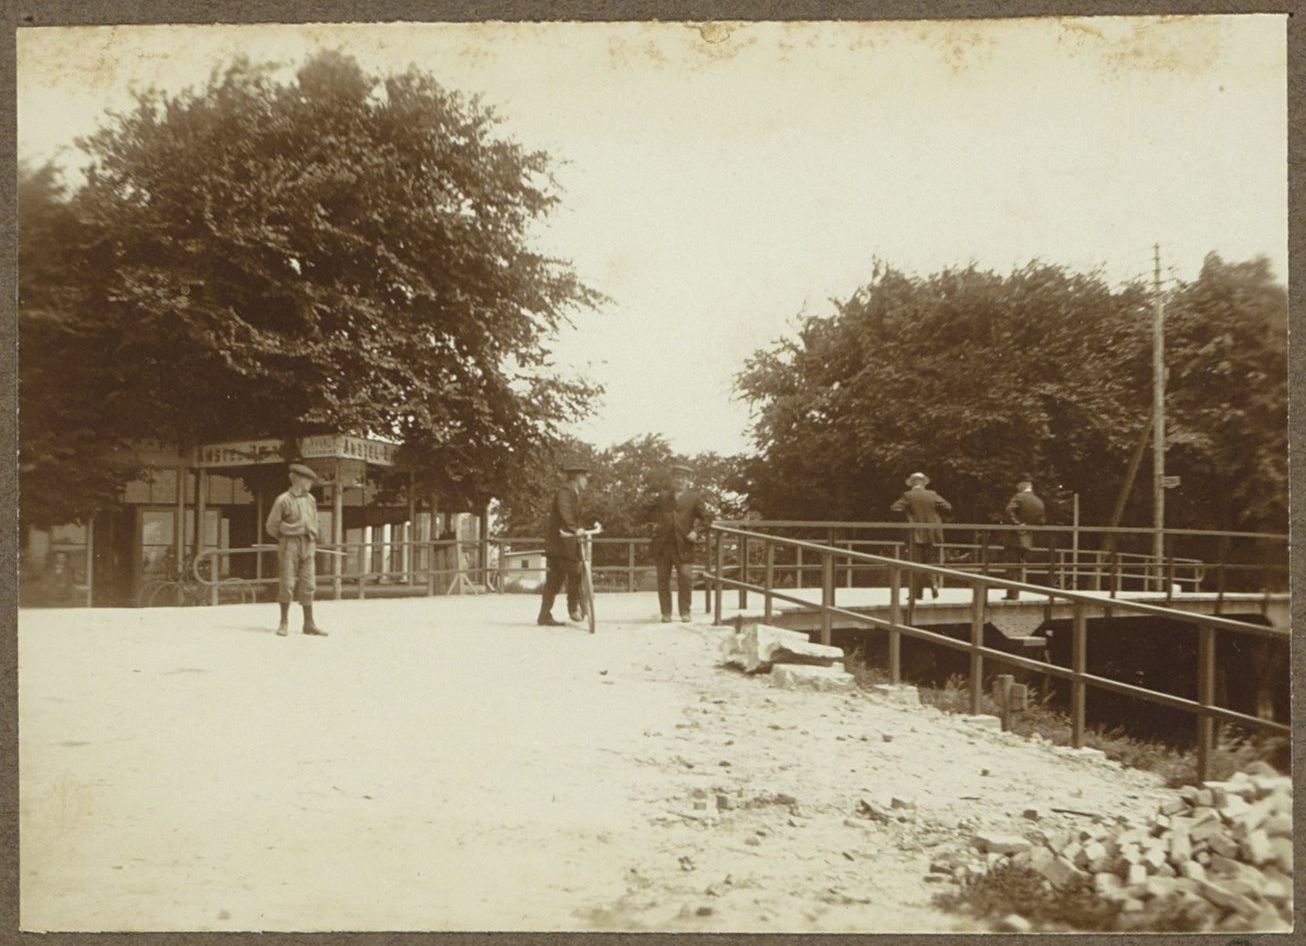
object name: photograph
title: Voorbijgangers bij de Hartveldse brug in Diemen, met op de achtergrond reclameborden voor Amstelbier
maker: Anonymous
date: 1910-1930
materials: paper, photographic support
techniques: gelatin silver print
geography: diemen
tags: advertising, bridge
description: Onderdeel van Album met foto's van Amsterdam en omgeving.